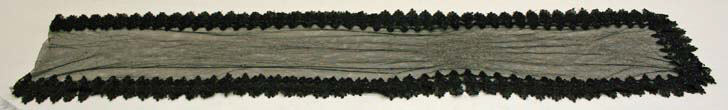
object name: fichu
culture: american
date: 1880-1889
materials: cotton, glass